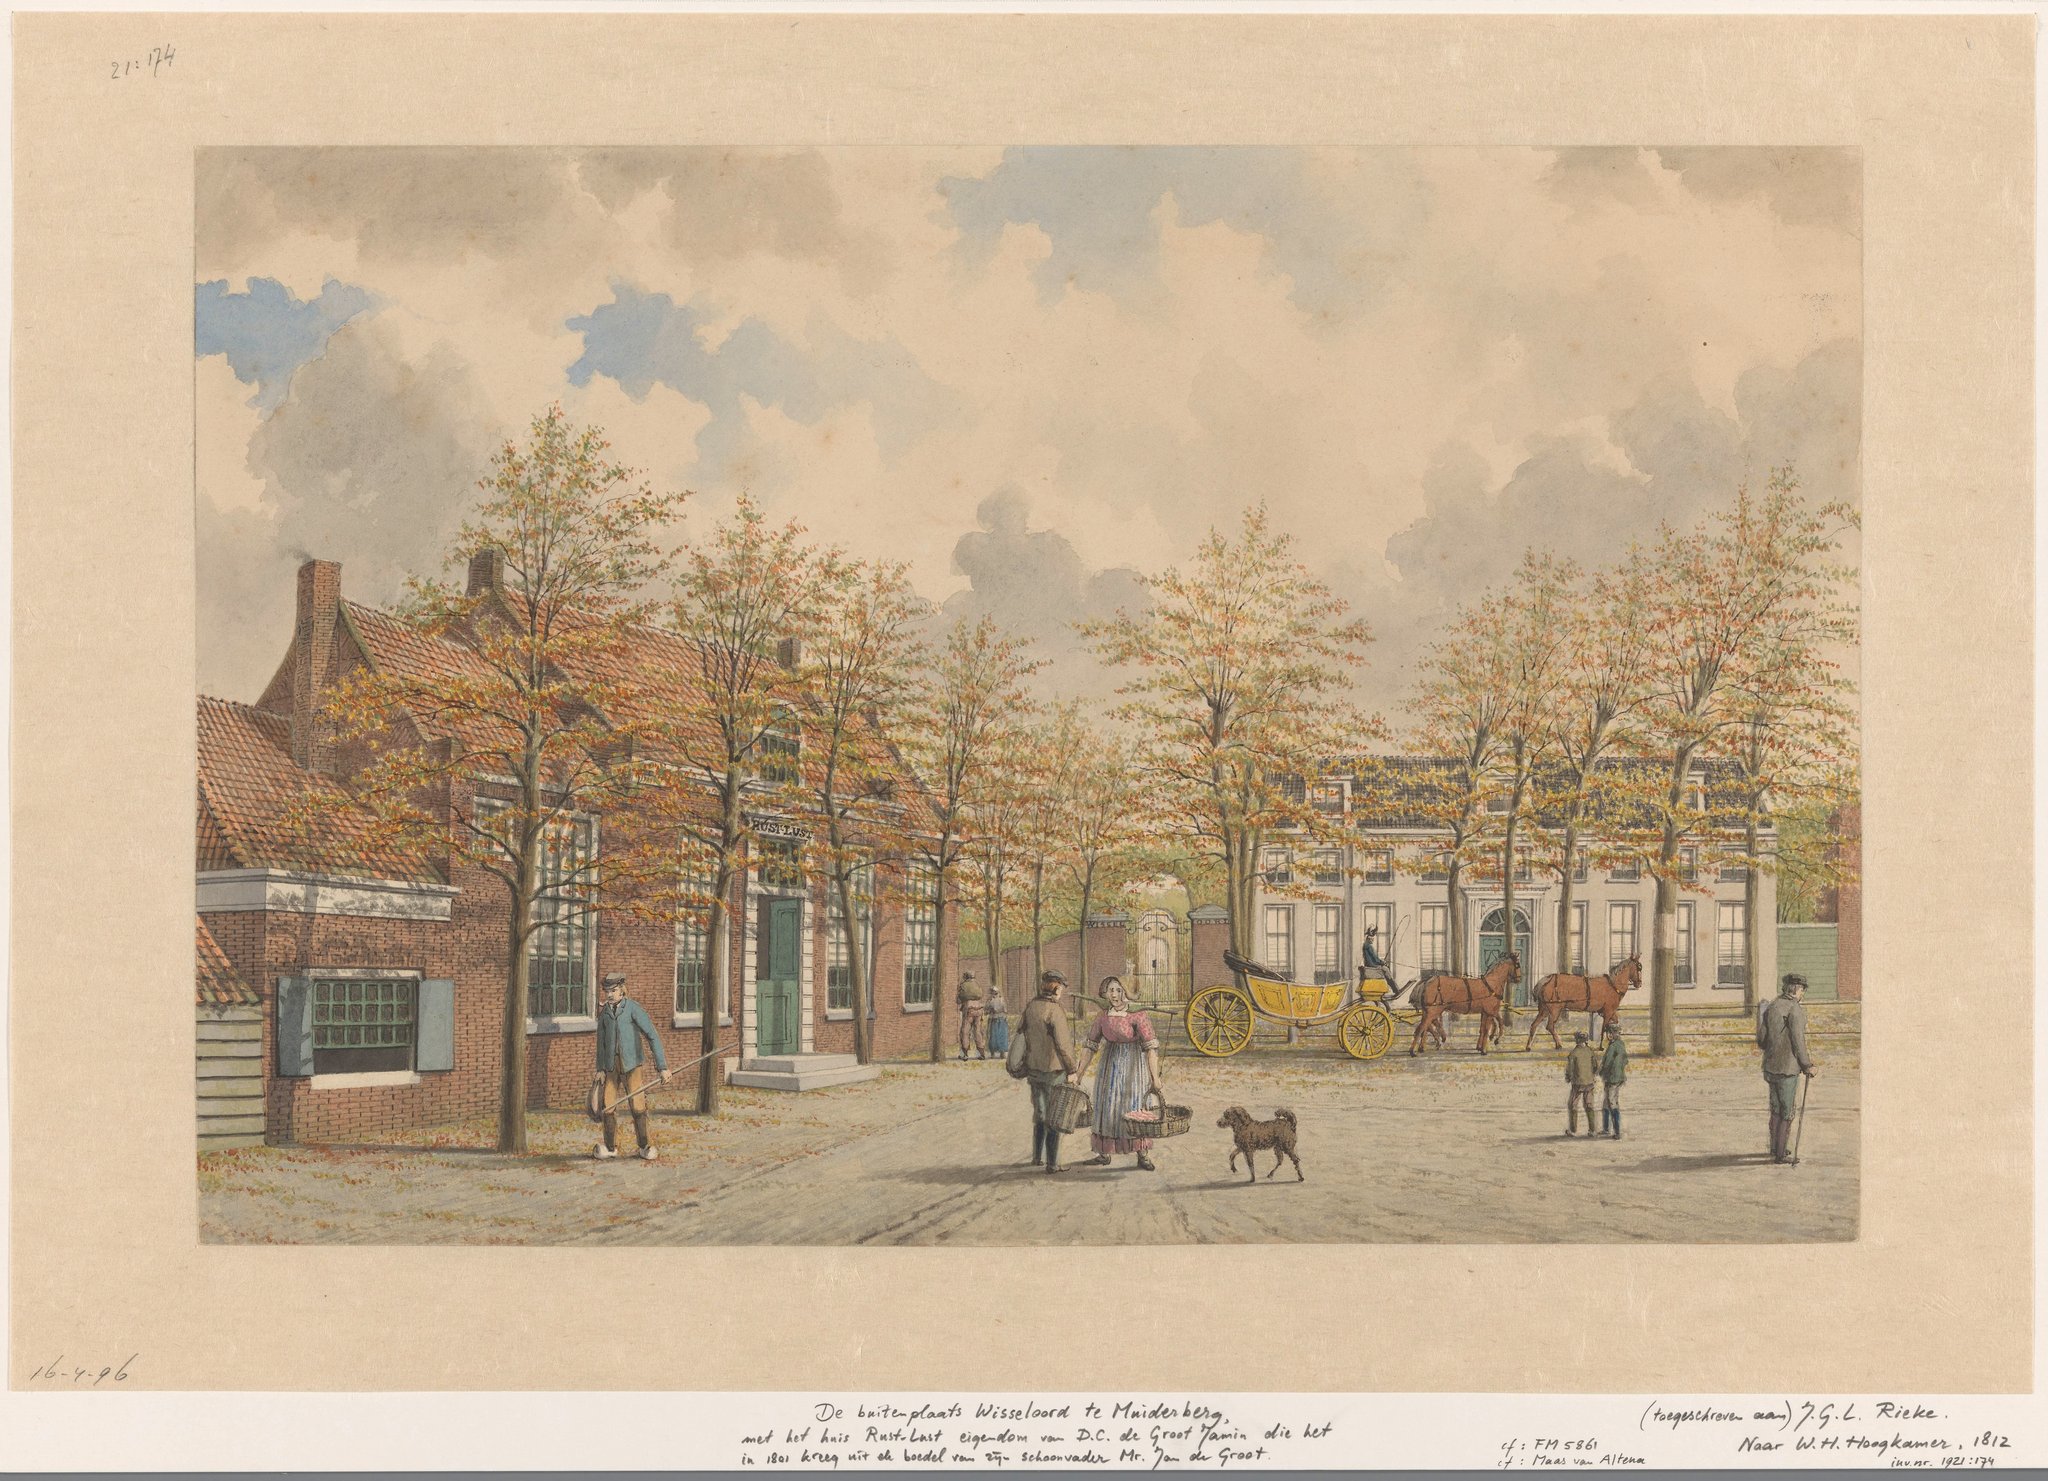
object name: watercolor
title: De buitenplaats Wisseloord te Muiderberg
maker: johan george lodewijk rieke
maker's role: draughtsman, print maker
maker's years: 1817-1898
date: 1827-1898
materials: ink, paper, pencil, watercolor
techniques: brush, pen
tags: prospect of village, silhouette of village, rural housing, e.g. country-house, villa, cottage